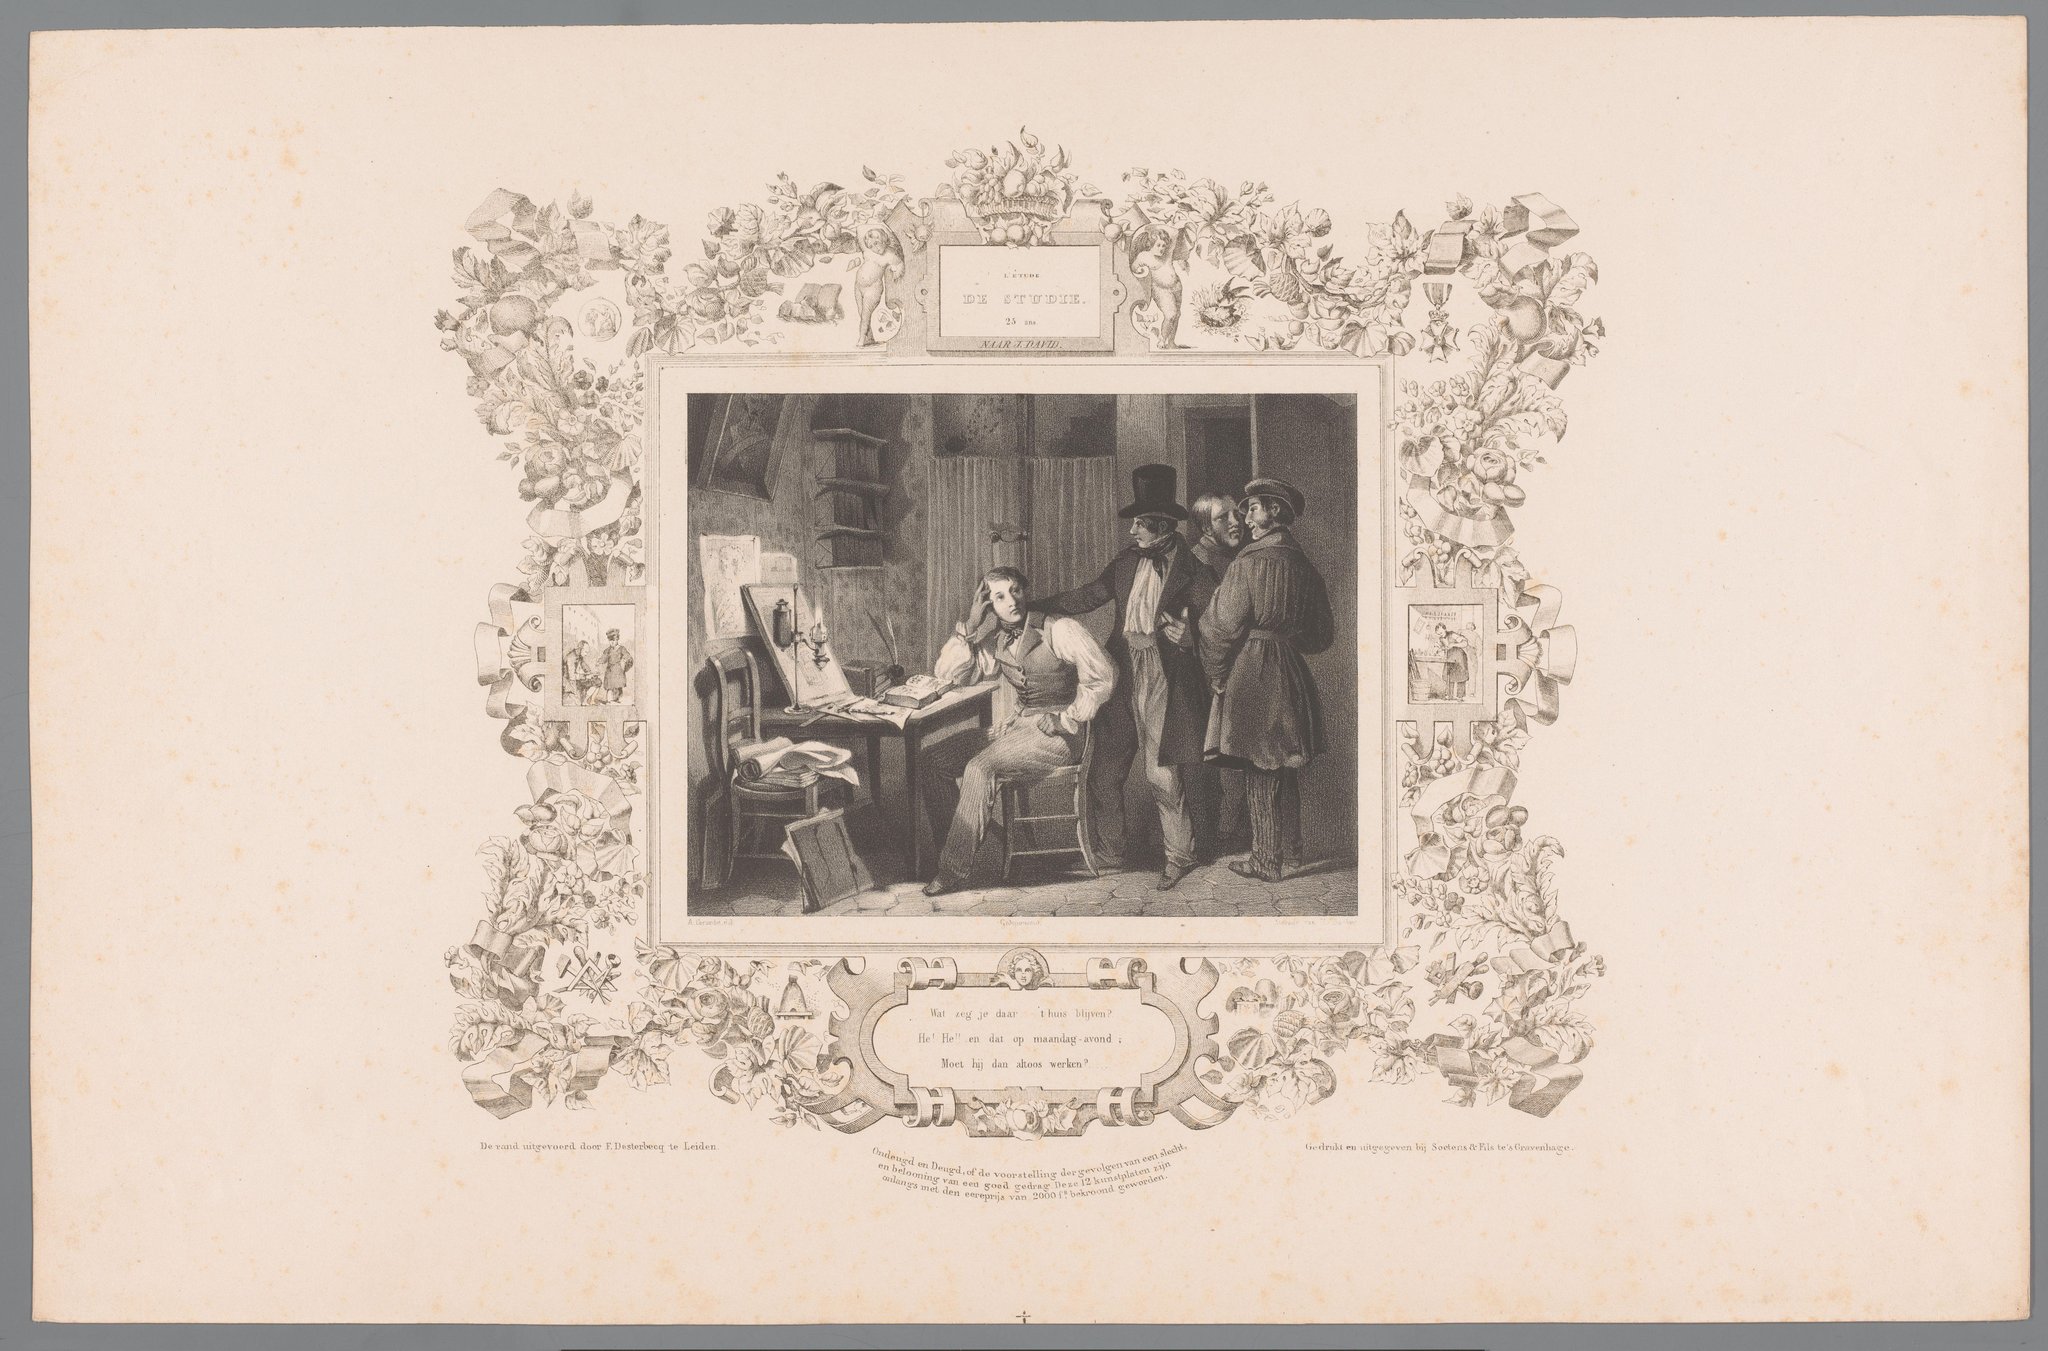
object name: print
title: Twaalf kunstplaten voorstellende de gevolgen en de belooning van ondeugd en deugd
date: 1837-1840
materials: paper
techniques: lithograph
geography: the hague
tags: scholar in his study, interior of the house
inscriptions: collector's mark: Lugt 2228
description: In de rand symbolen die verwijzen naar deugd zoals het geven van een aalmoes, noeste arbeid en een ridderorde.